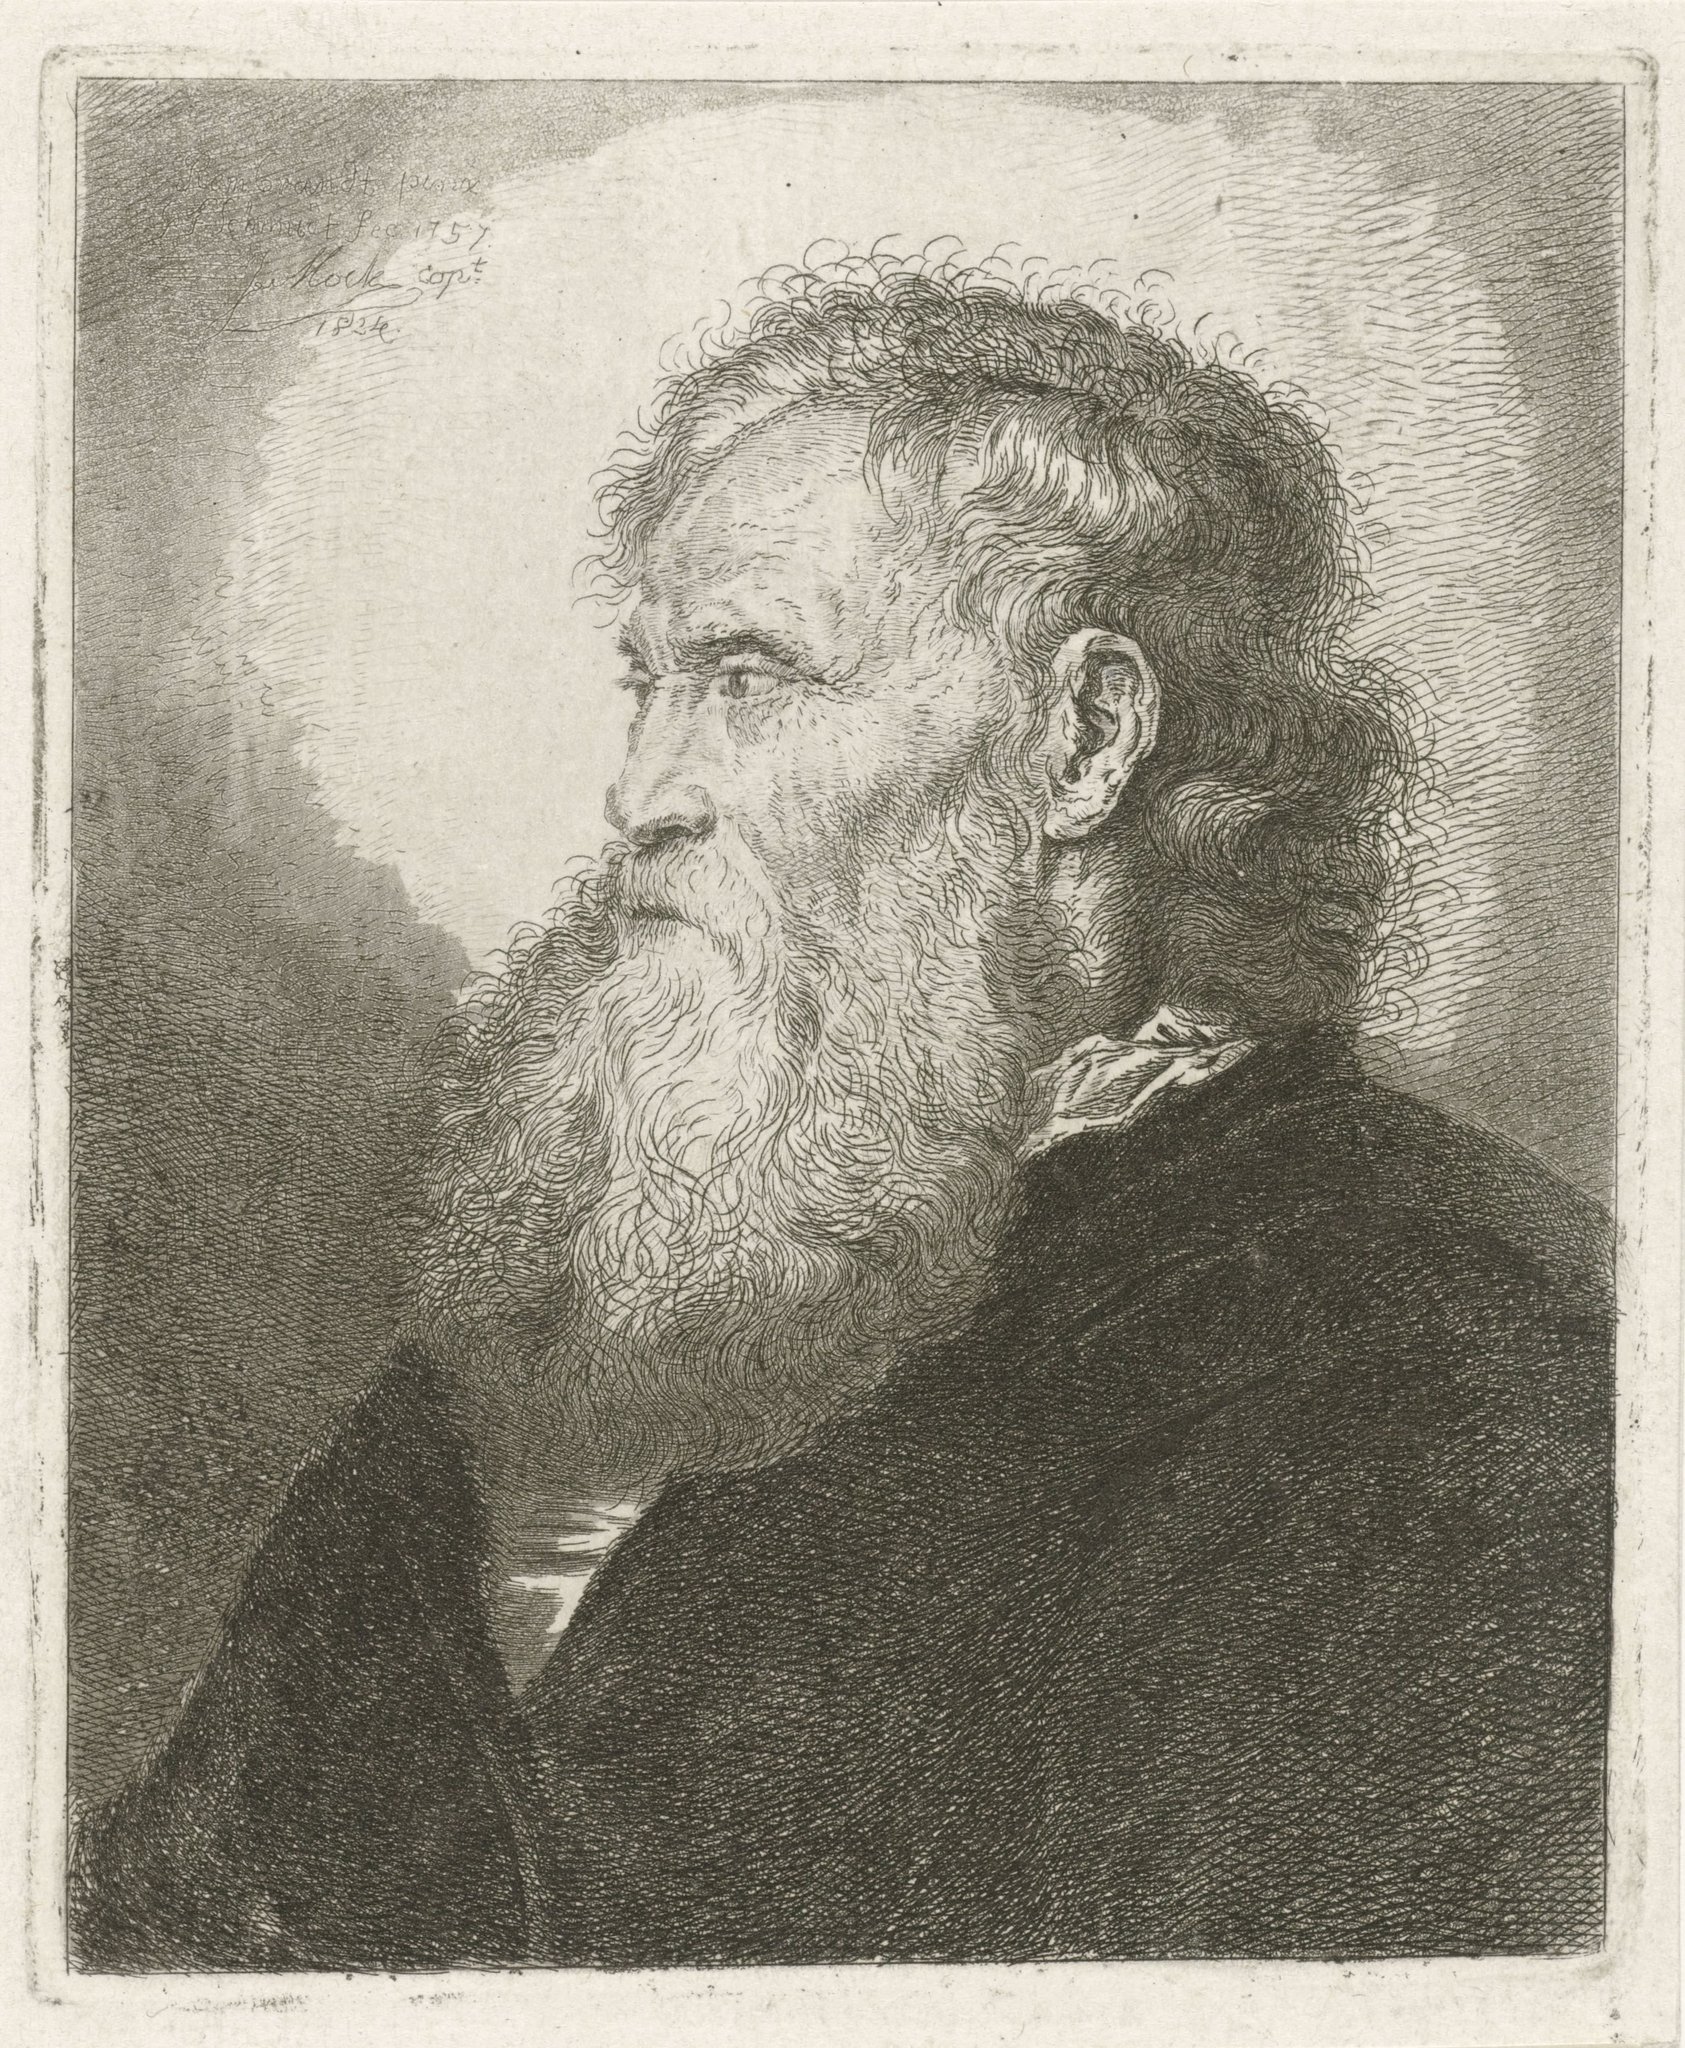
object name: print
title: Portret van een oude man met baard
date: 1824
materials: paper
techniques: aquatint, etching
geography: netherlands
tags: old man, beard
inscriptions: collector's mark: Lugt 2228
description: Portret van een oude man met baard, gekleed in een jas.